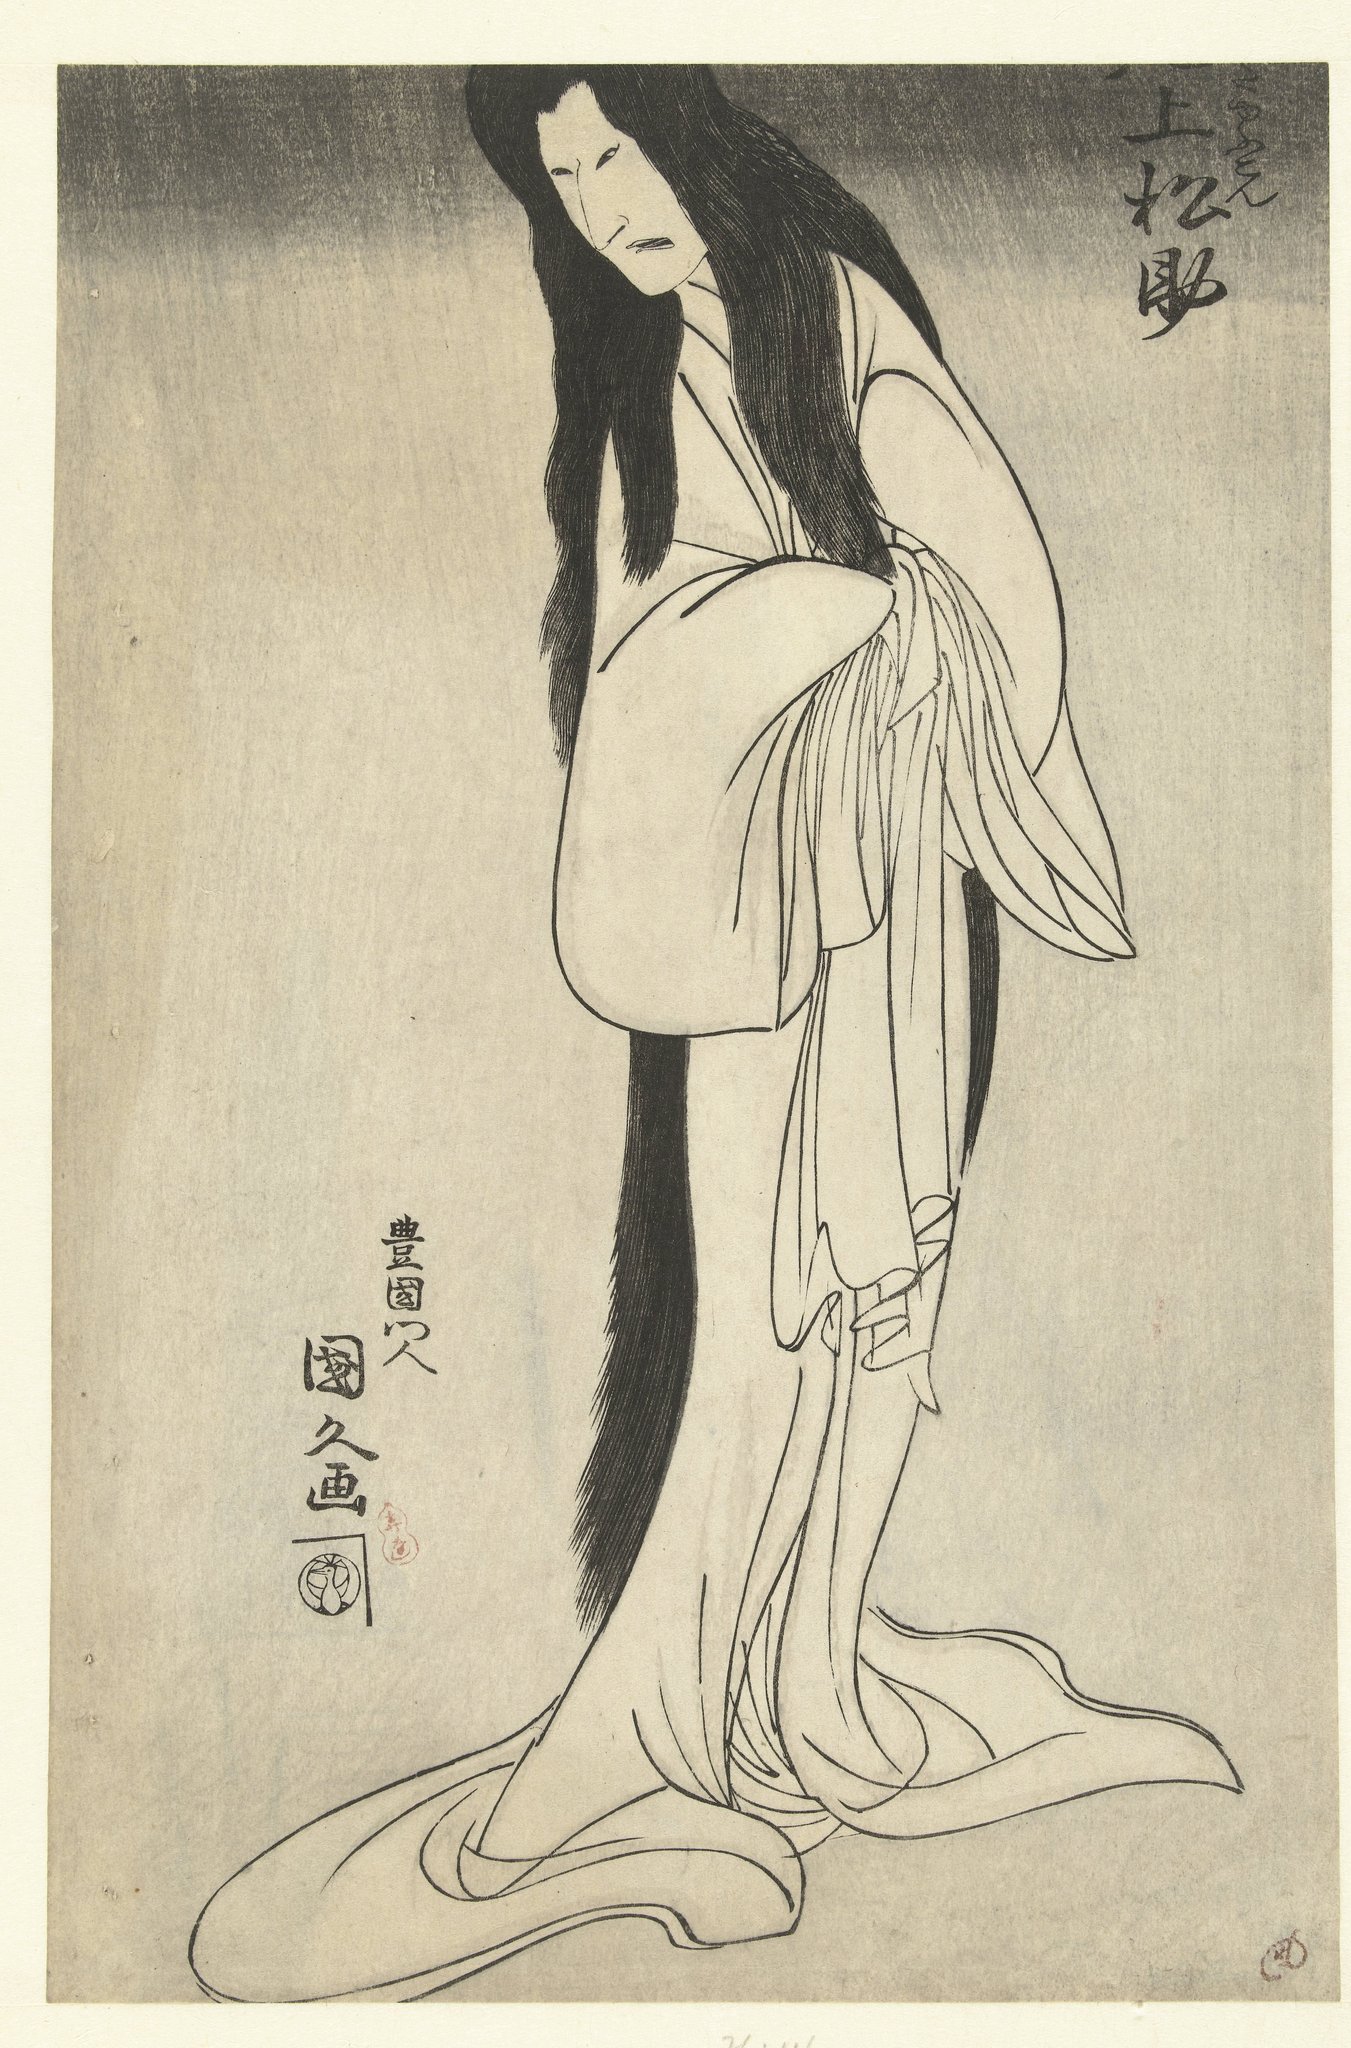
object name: print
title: Onoe Matsusuke I als vrouwelijk spook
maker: utagawa kunihisa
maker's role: print maker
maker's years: 1832-1891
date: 1805-1810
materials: paper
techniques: nishiki e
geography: tokyo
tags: portrait of actor, actress, spirit, ghost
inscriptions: collector's mark: ‘v D’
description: De acteur Onoe Matsusuke I in de rol van vrouwelijk spook, met wit kostuum en lange zwarte pruik; tegen grijze achtergrond.